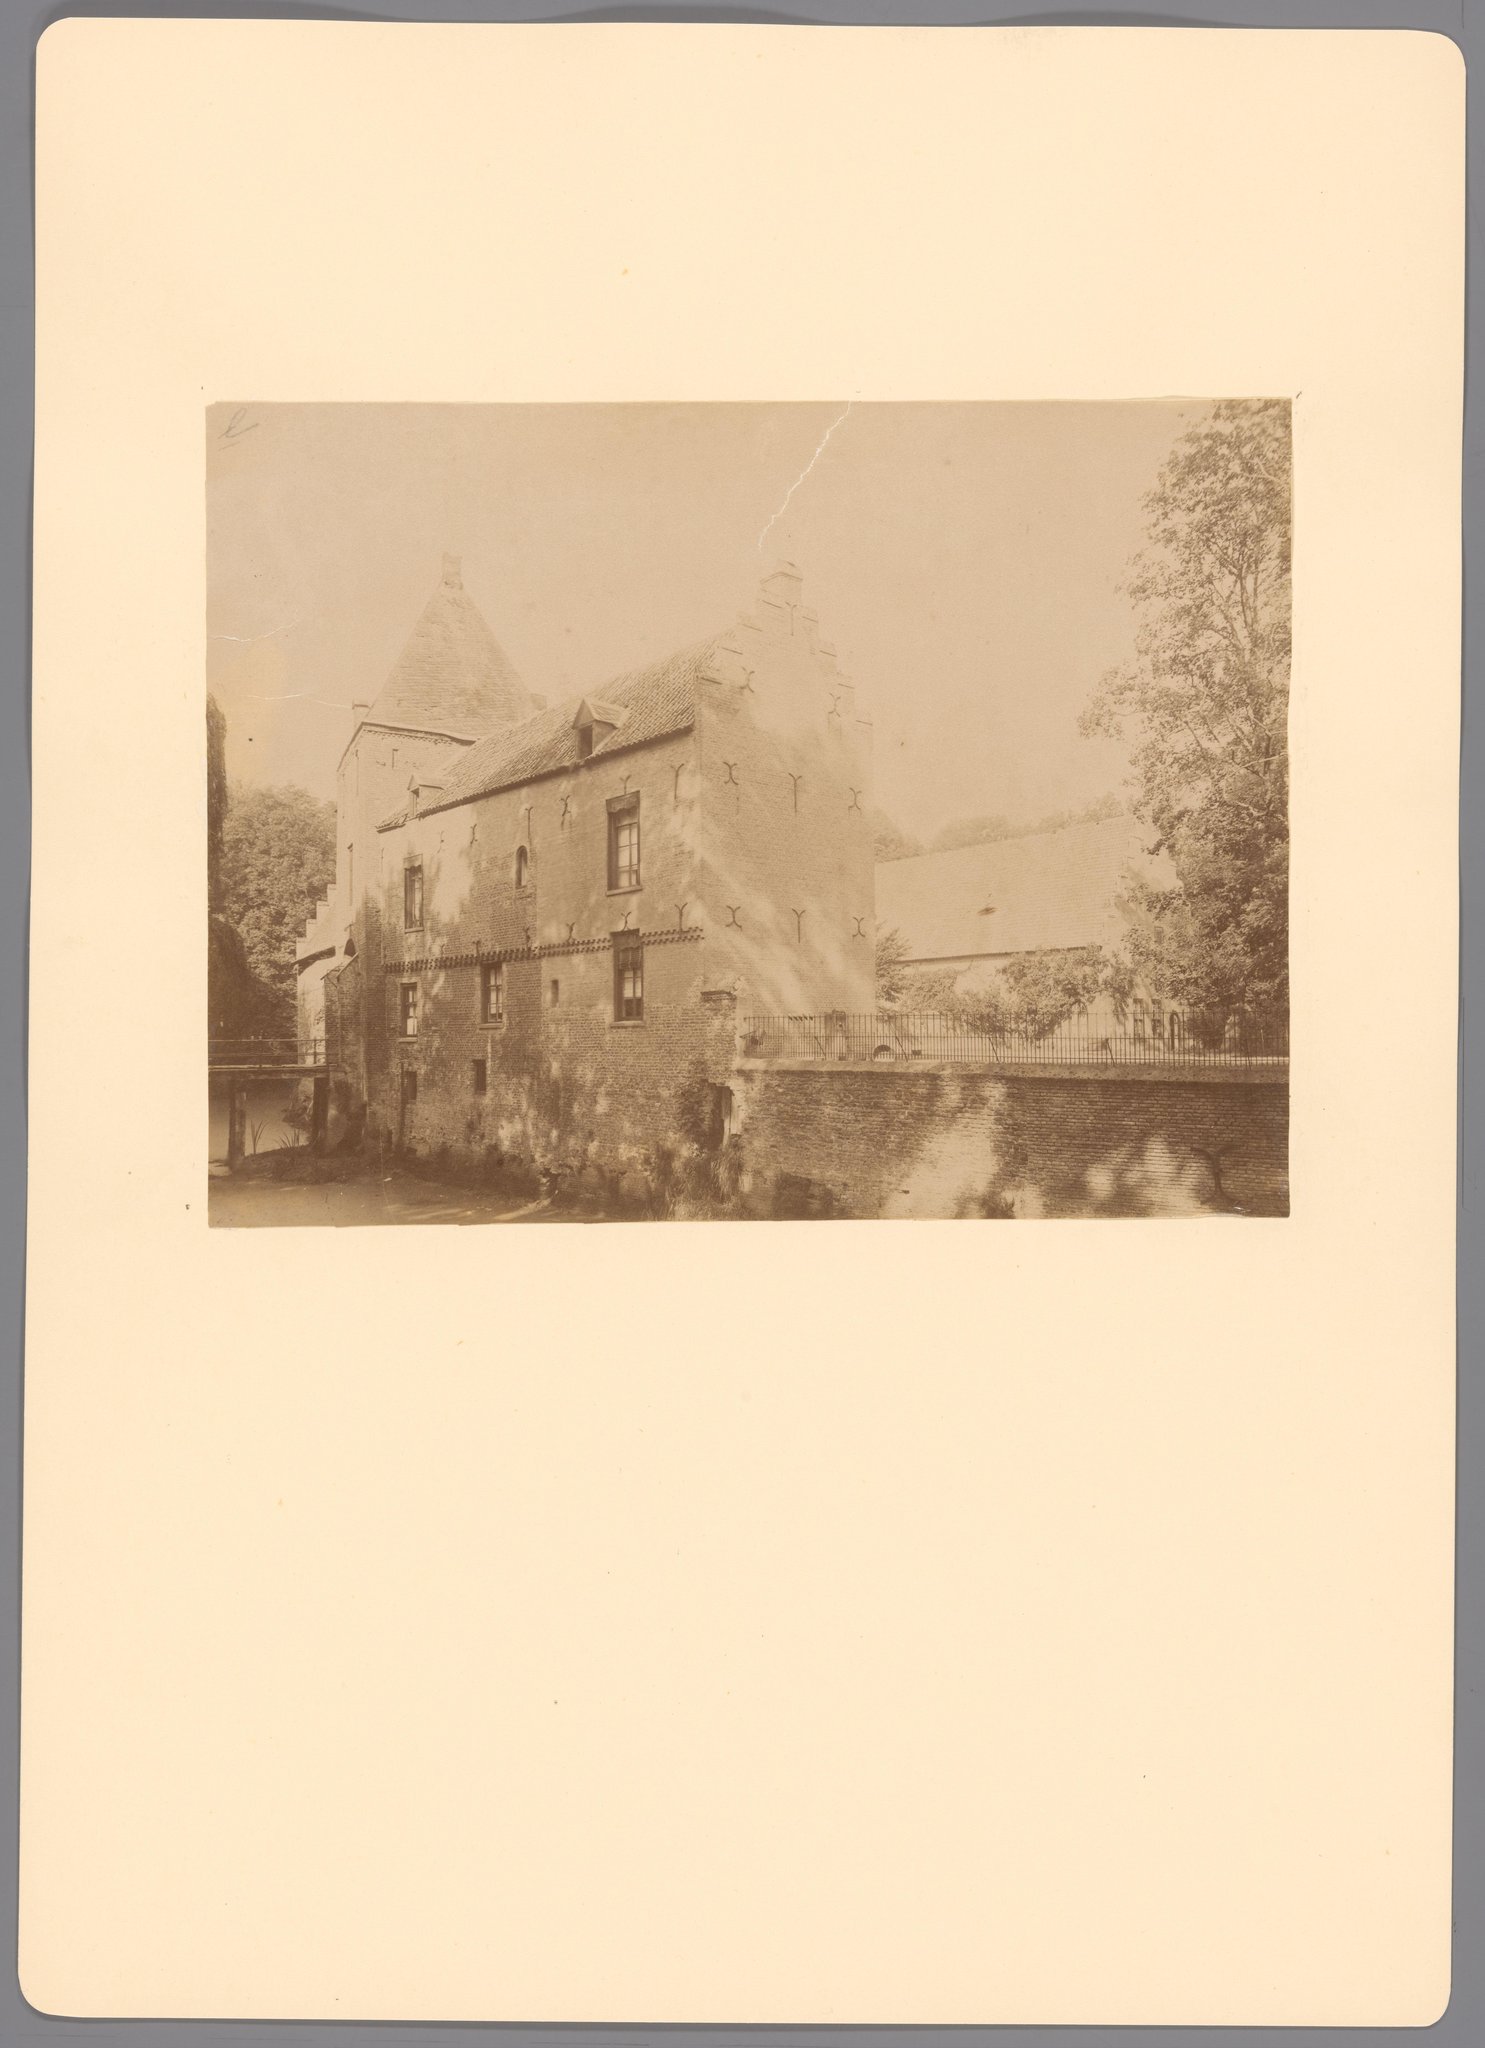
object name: photograph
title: Gezicht op Kasteel Doorwerth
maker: anoniem (monumentenzorg)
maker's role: fotograaf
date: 1890-1920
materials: cardboard, photographic support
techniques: albumen print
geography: kasteel doorwerth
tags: castle, landscape with tower or castle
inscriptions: annotation: ‘l’, annotation: ‘Kasteel Doorwerth/ Hoofdingang bij gebouw a’